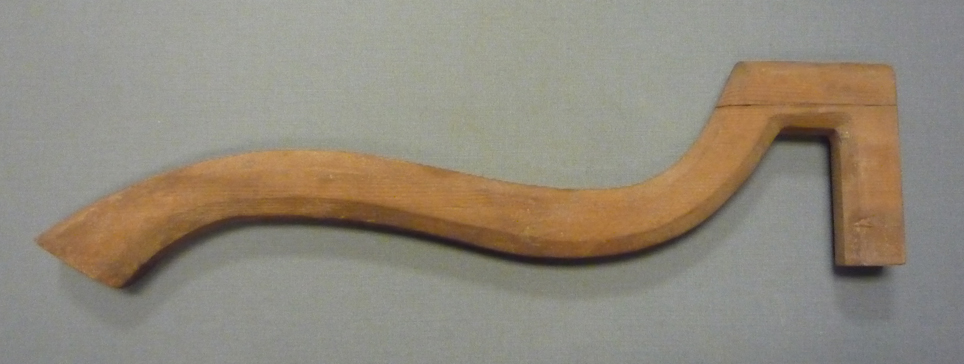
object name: tool, mesekhetyu, hatshepsut foundation deposit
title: Ritual tool for the "Opening of the Mouth" ceremony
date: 1479-1458 BCE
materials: wood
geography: egypt